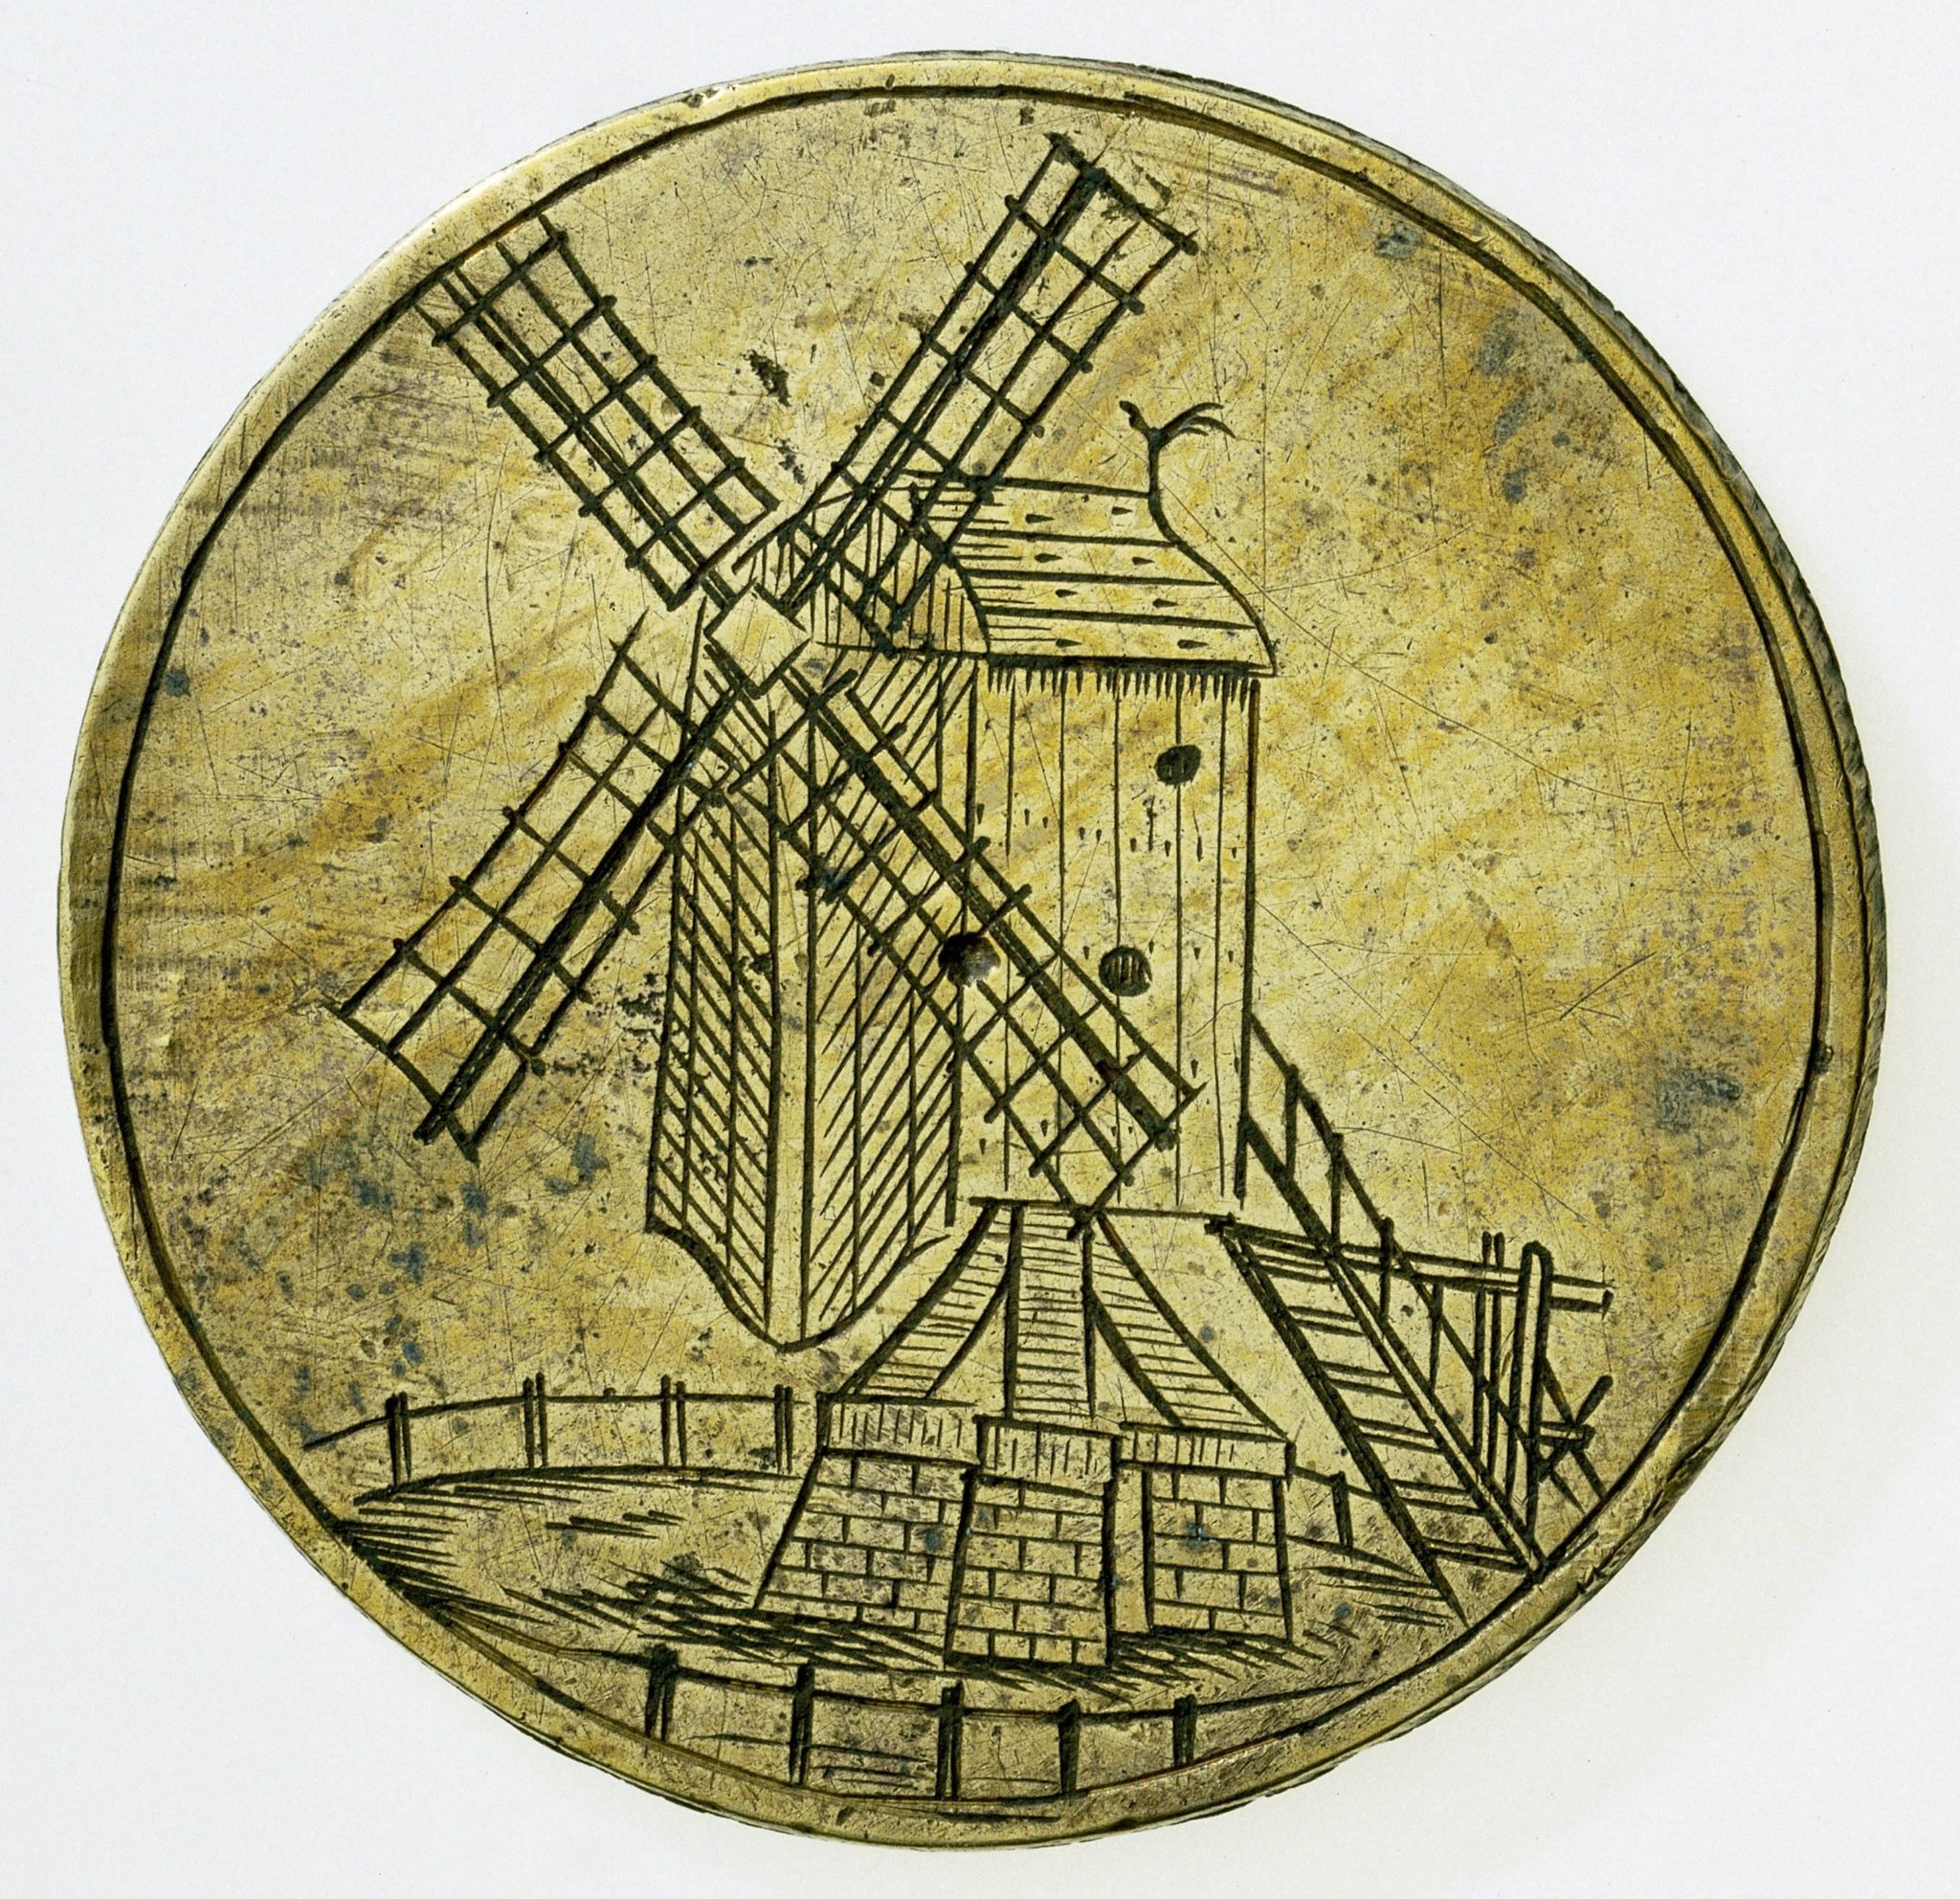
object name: medal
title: Korenmolenaarsgilde van Amsterdam, gildepenning van Jan van Bemmiel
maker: Anonymous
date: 1723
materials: brass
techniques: engraving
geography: amsterdam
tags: jan van bemmiel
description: Guilds were urban organisations of people in specific occupations. The guild represented the interests of the profession. Each member had a token as proof of membership. The person’s name was engraved on one side of the token, often together with the arms of the guild or of the city in which it was based. The other side carried a motif signifying the occupation represented by the guild.